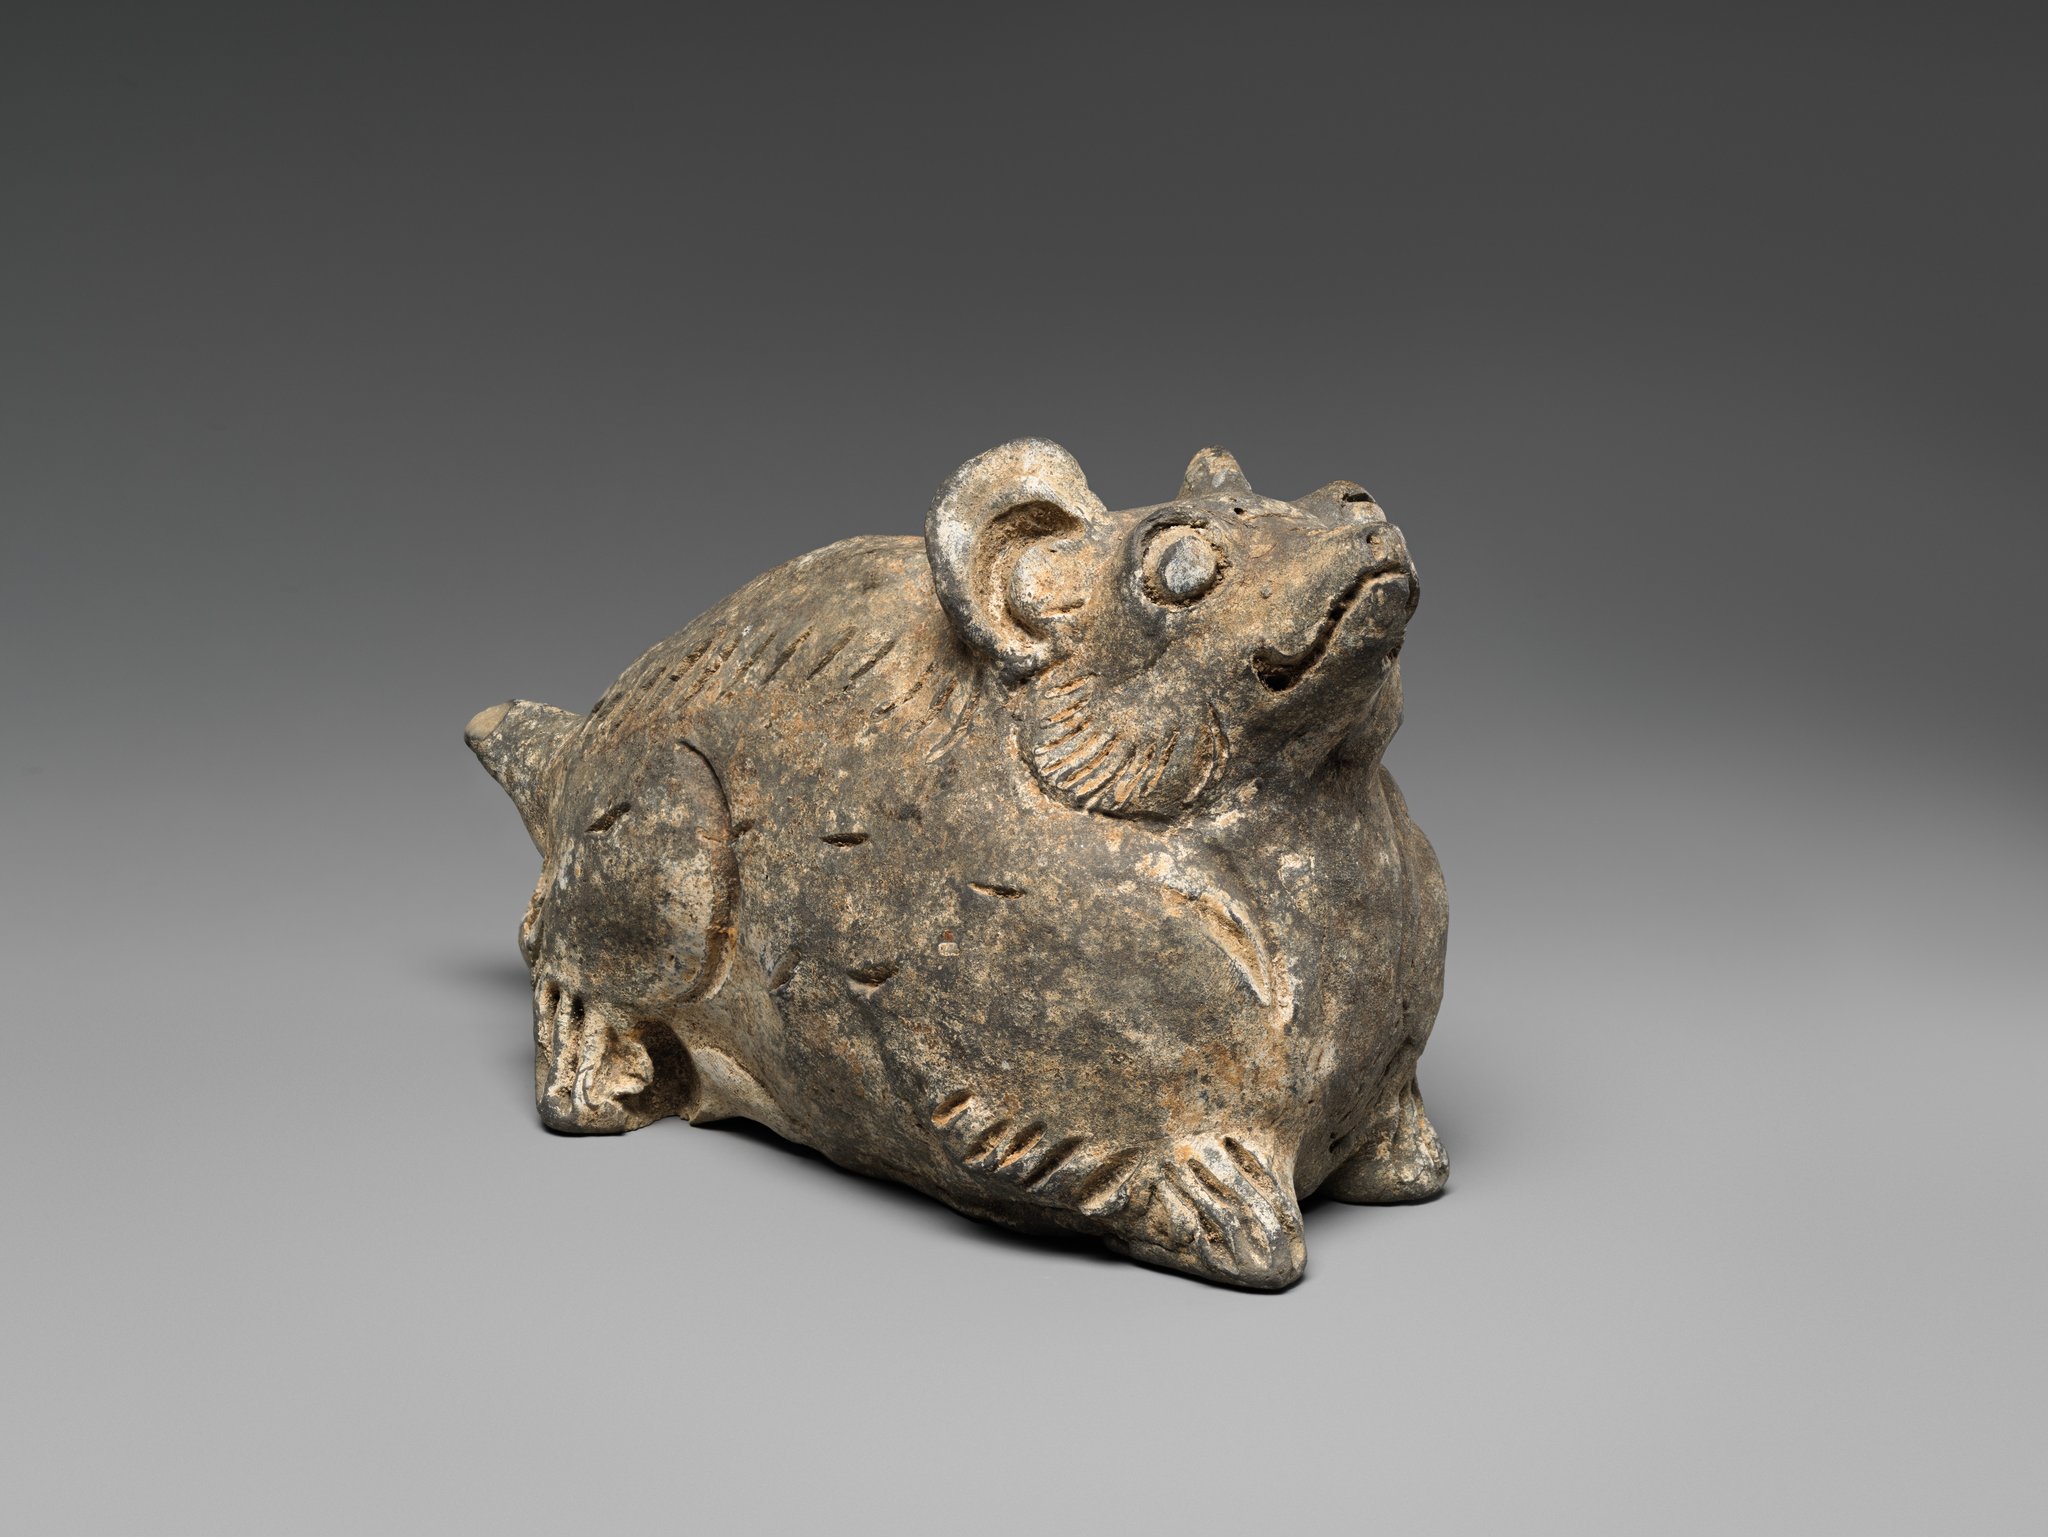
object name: tomb figure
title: Tomb Figure of Rat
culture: chinese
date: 1201-1300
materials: earthenware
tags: rats